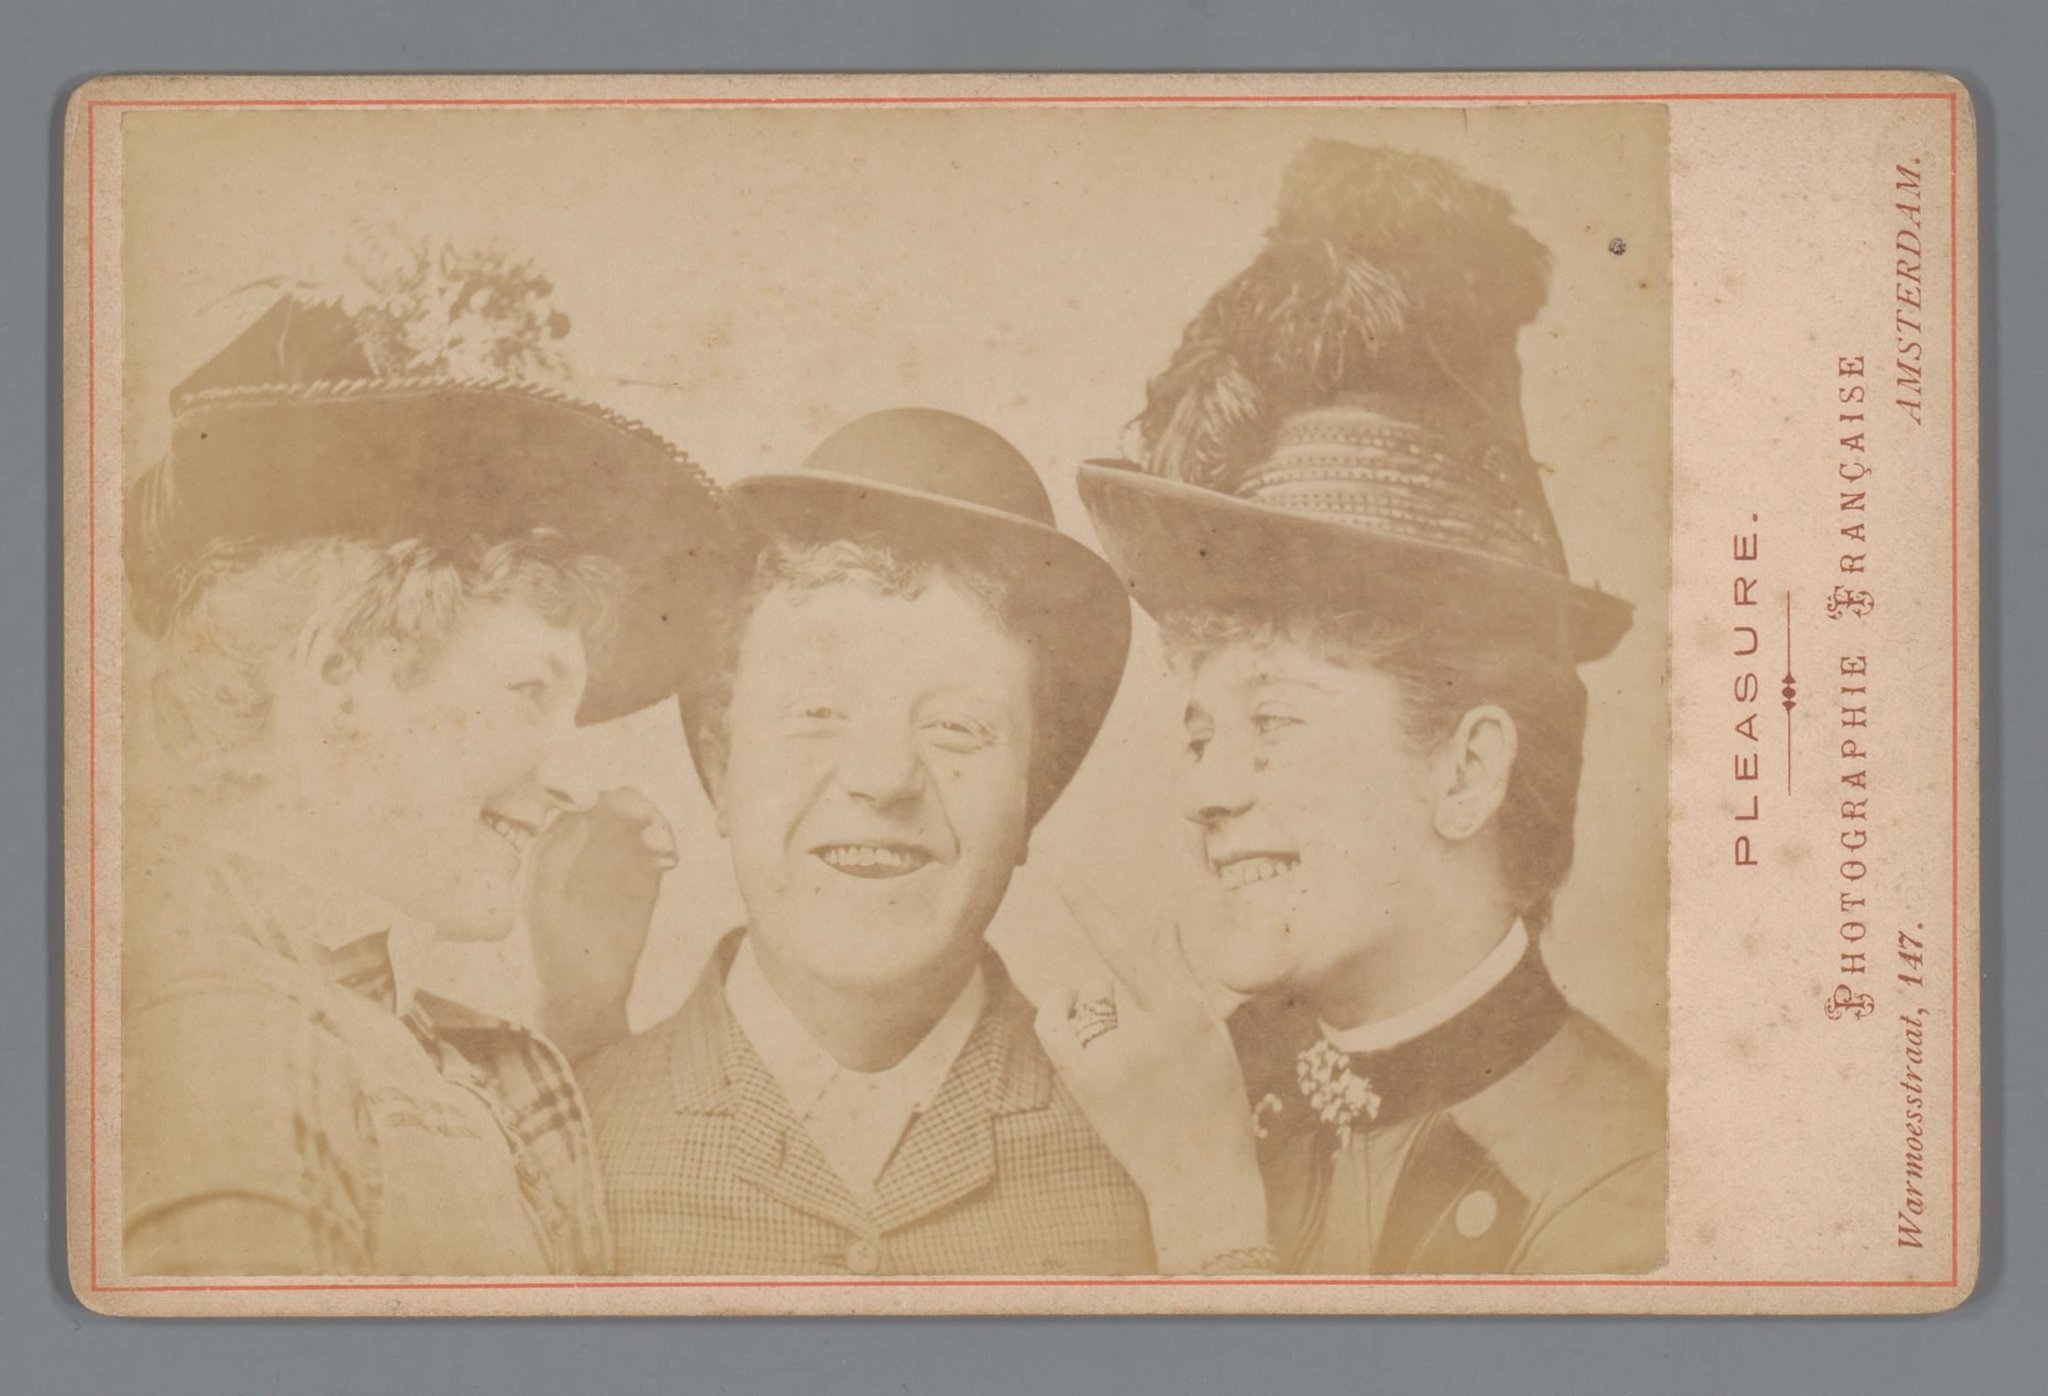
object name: cabinet photograph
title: Portret van een lachende man en twee lachende vrouwen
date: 1870-1895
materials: cardboard, photographic support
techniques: albumen print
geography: amsterdam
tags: adult woman, adult man, anonymous historical persons portrayed in a group, in a group-portrait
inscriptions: name: ‘Pleasure Photographie Française Warmoesstraat, 147. Amsterdam’